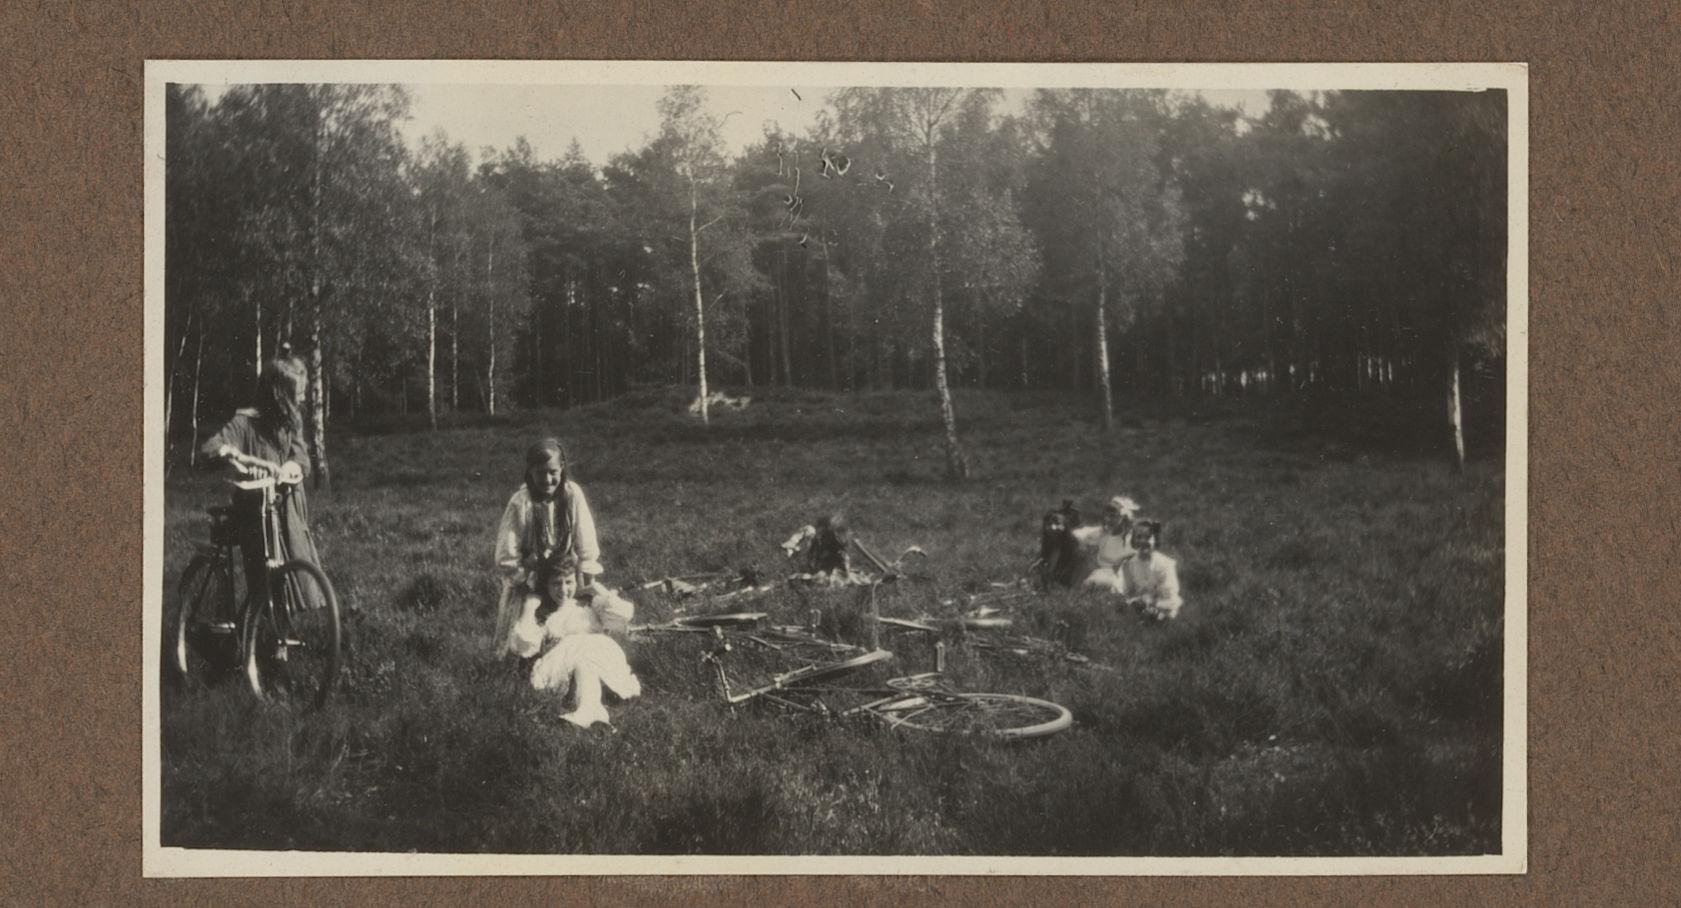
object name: photograph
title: Vier mensen met fietsen in een veld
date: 1900-1915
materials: photographic support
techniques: photography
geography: netherlands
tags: netherlands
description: Foto op bruin albumblad 52 van familiealbum van Alphons Diepenbrock.